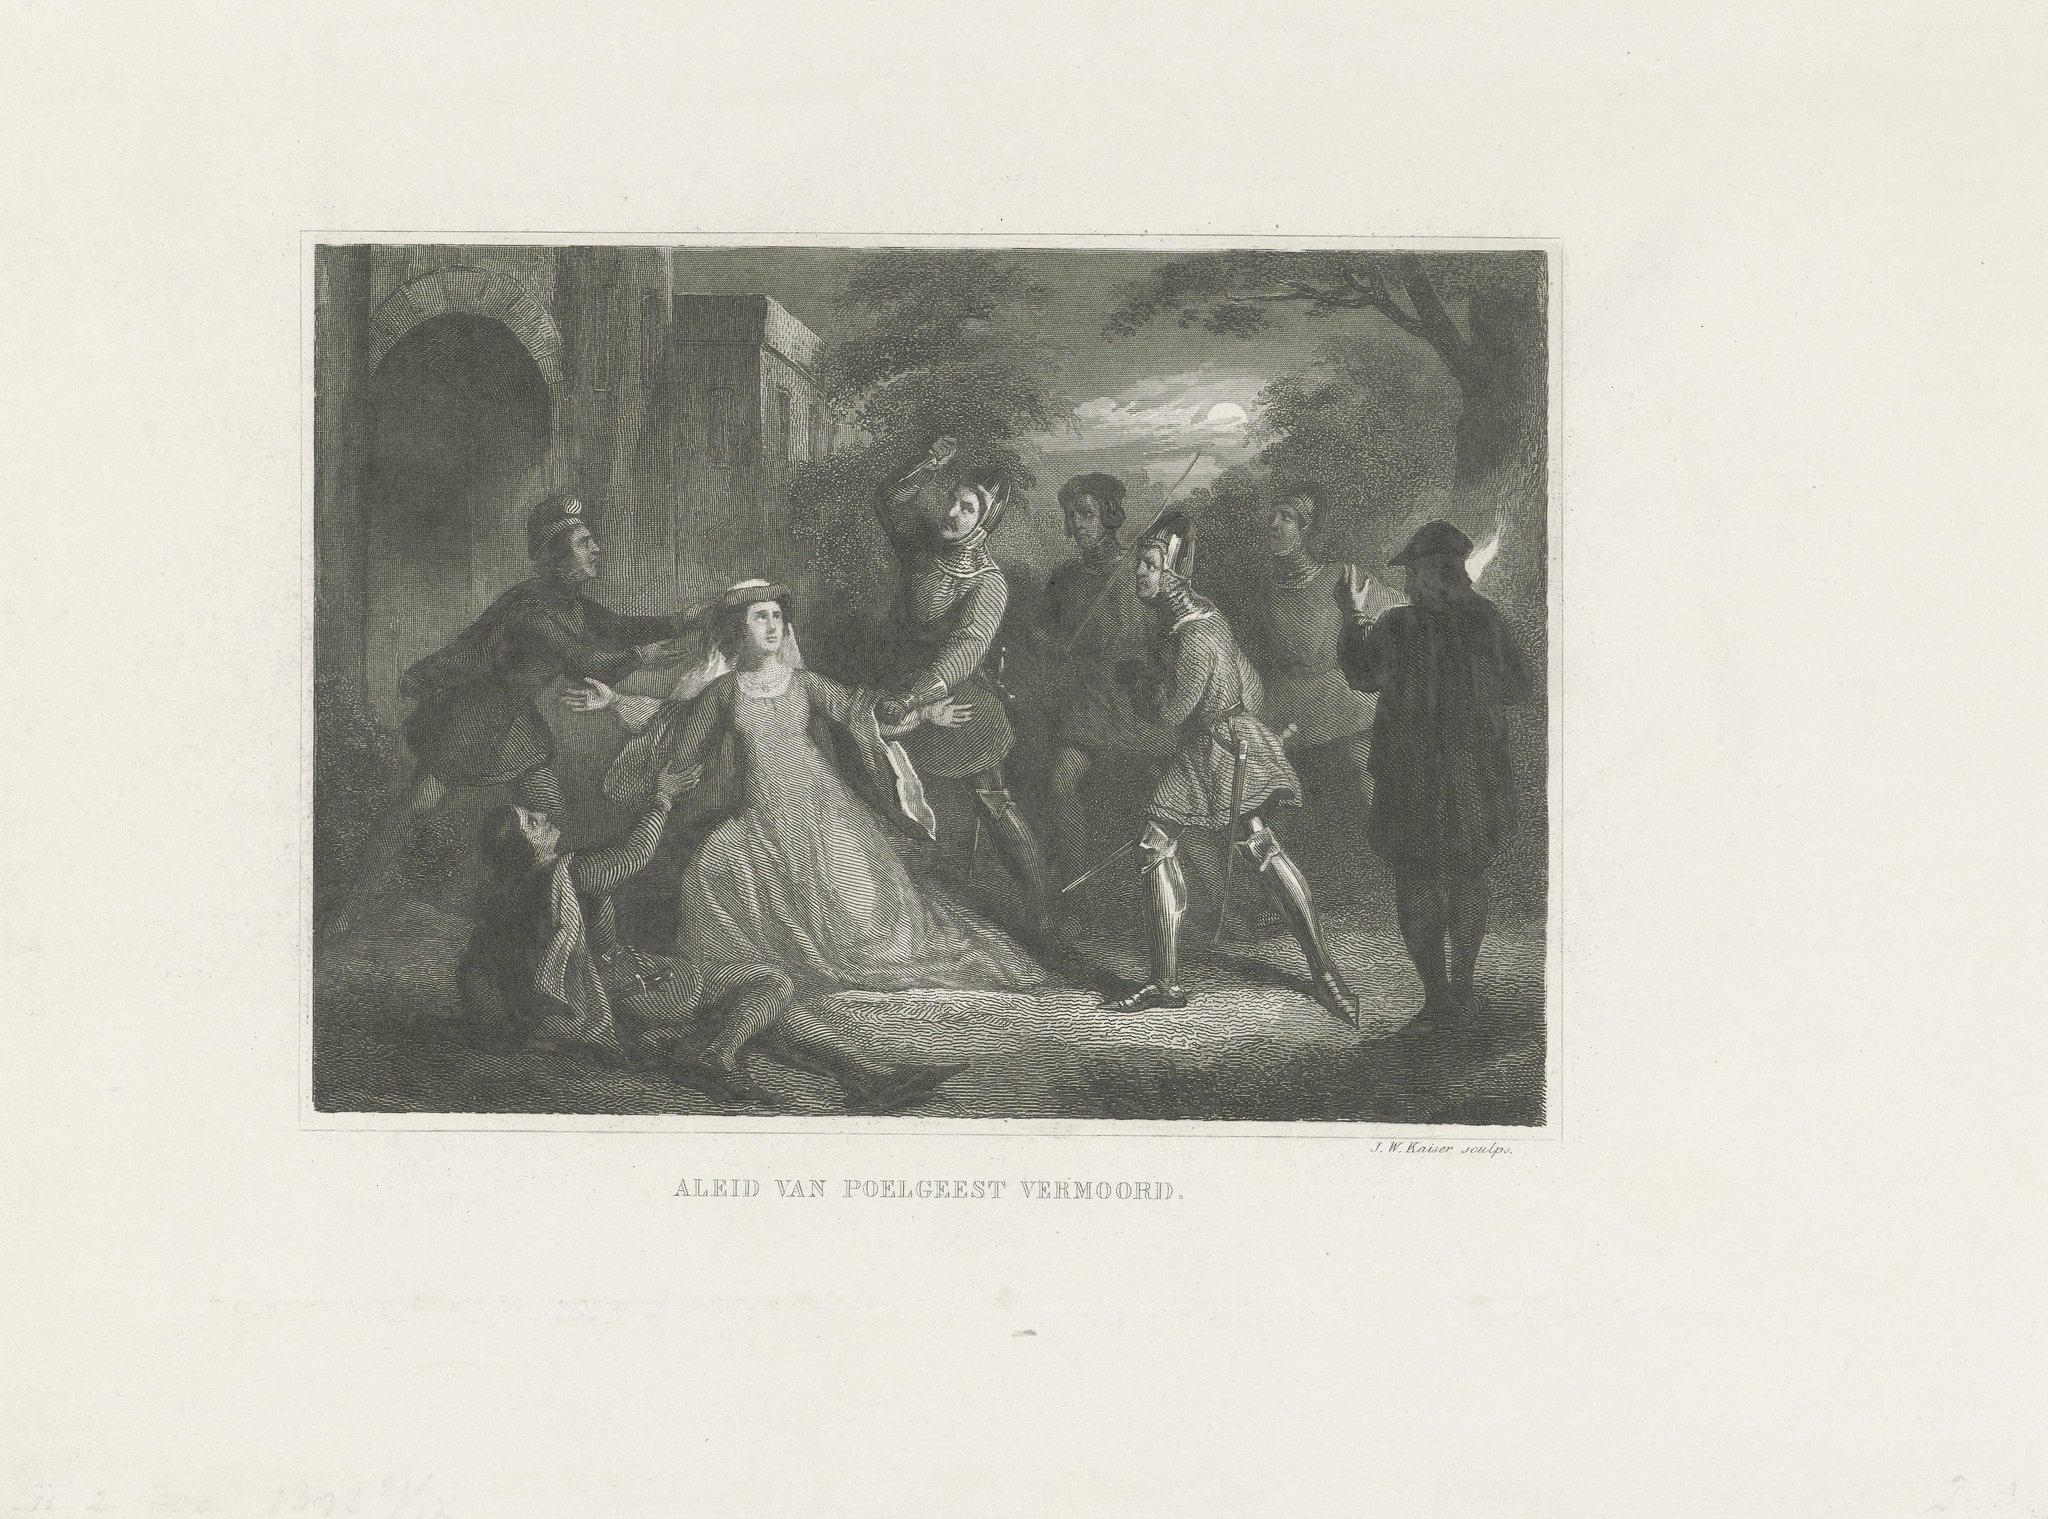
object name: print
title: Moord op Aleid van Poelgeest, 1392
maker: johann wilhelm kaiser (i)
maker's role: draughtsman, print maker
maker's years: 1813-1900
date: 1840-1884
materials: paper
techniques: engraving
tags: the hague, netherlands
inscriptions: collector's mark: Lugt 2228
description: Jonkvrouw Aleid van Poelgeest wordt 's nachts buiten het kasteel vermoord door een aantal Hoekse soldaten, op 22 september 1392. Een van de soldaten schijnt bij met een fakkel en een ander staat op het punt de jonkvrouw met een dolk van het leven te beroven.